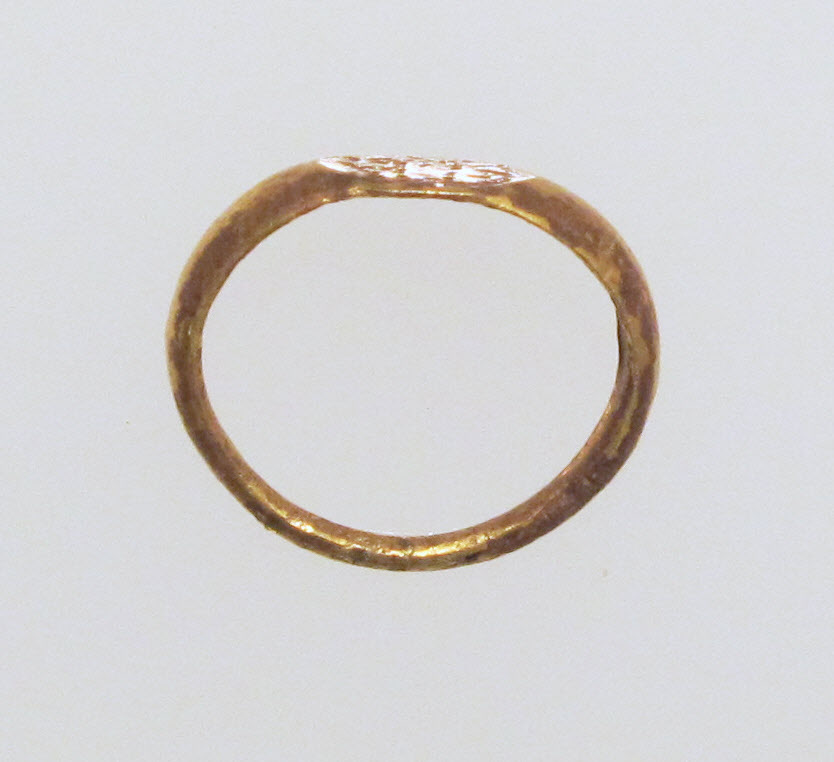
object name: ring, motto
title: Gold ring with inscribed bezel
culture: roman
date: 100 BCE-300 CE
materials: gold